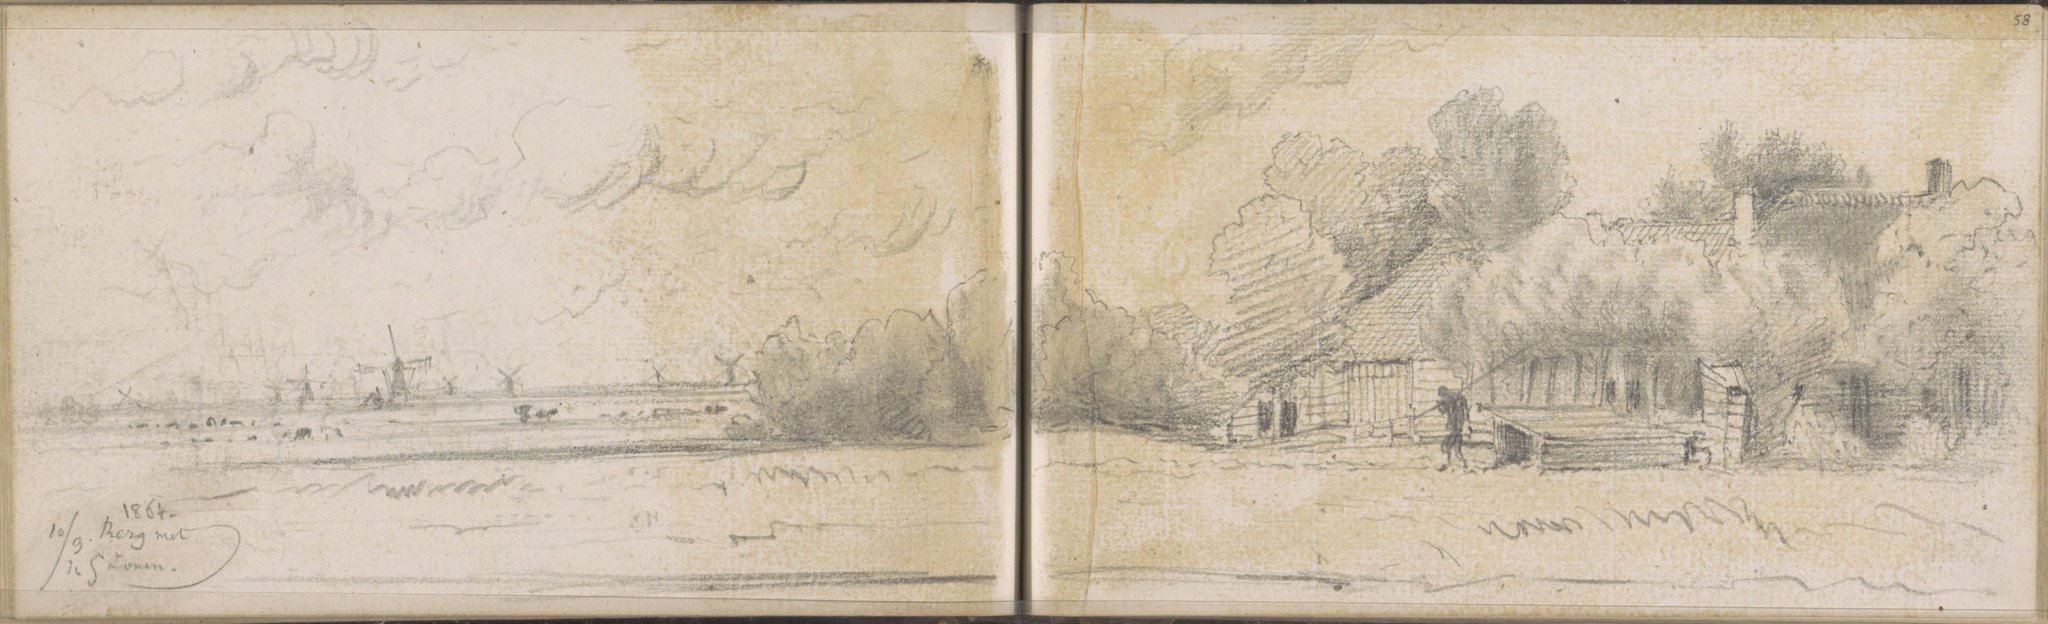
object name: sketchbook leaf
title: Landschap met molens, vee en een huis tussen de bomen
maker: johannes tavenraat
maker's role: draughtsman, painter, print maker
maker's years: 1809-1881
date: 1809-1864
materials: ink, paper, pencil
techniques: brush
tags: landscapes, cattle, rural housing, e.g. country-house, villa, cottage, windmill in landscape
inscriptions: date and inscription: ‘1864/ 10/9 Berg met/ [...]onen.’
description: Blad 57 verso en 58 recto uit een schetsboek met 98 bladen.